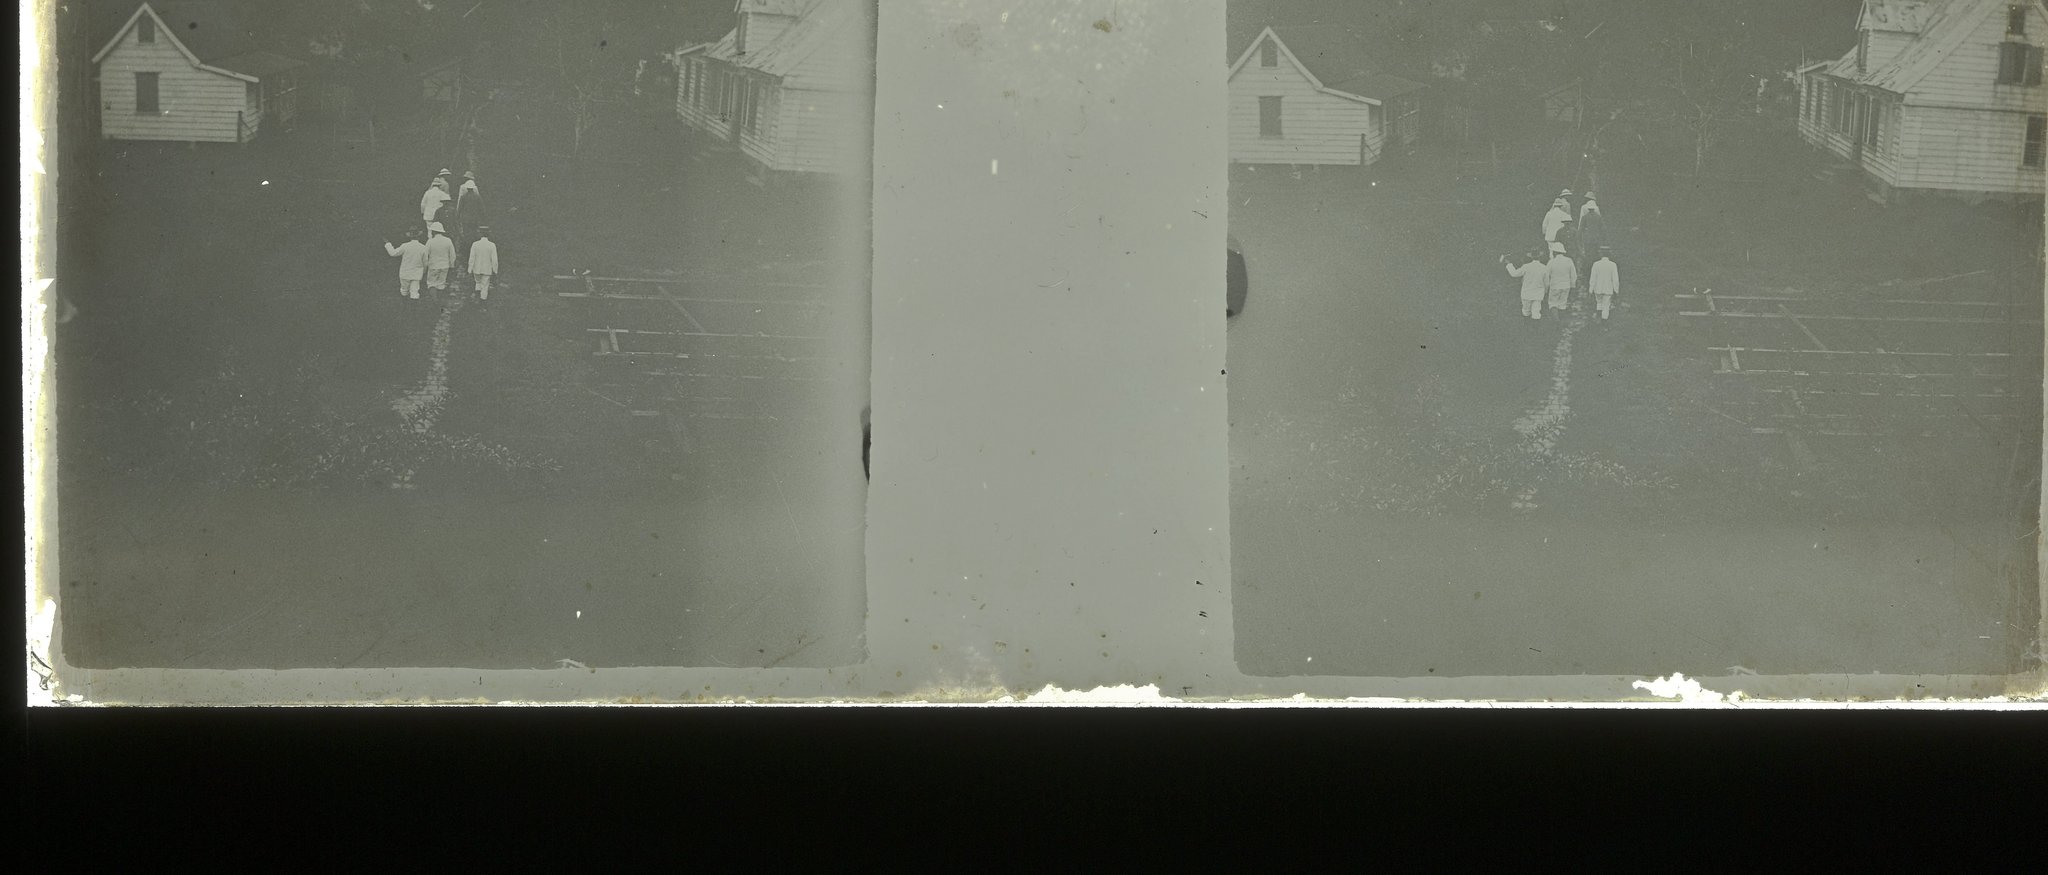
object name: stereograph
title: Plantage Accaribo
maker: theodoor brouwers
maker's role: amateurfotograaf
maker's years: 1874-1932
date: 1913-1930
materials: glass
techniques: photography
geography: suriname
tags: amsterdam, theodoor brouwers, plantation, suriname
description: In de periode 1911-1932 woonde op plantage Accaribo in Suriname de familie Brouwers van wie de foto's afkomstig zijn. Rond 1910 vond Theodoor Brouwers werk op plantage Accaribo. In 1929 werd hij eigenaar van de plantage. Op Accaribo werden in zijn tijd bananen geproduceerd en wat koffie.